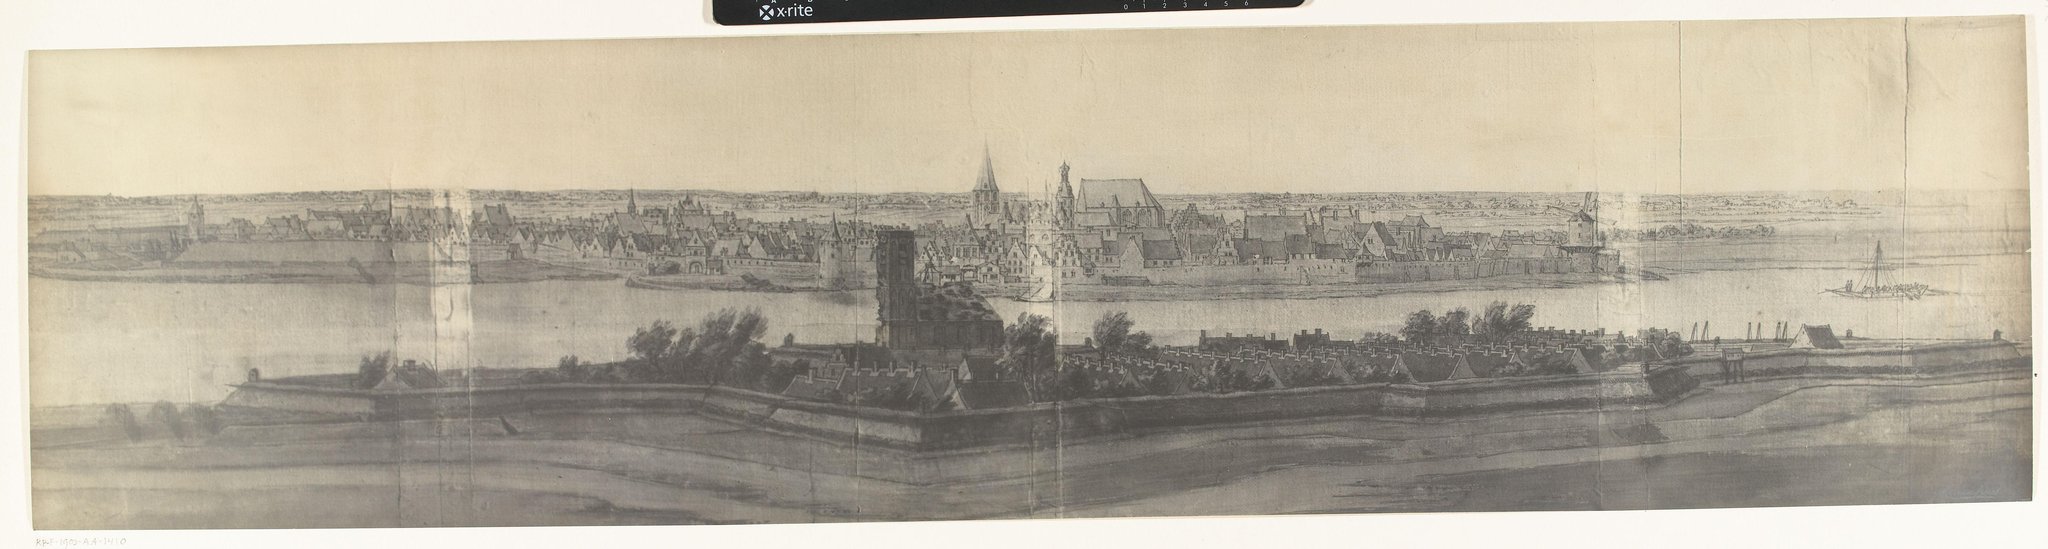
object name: photograph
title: Foto's van tekeningen van de Franse inval in de Nederlanden in 1672 door Adam Frans van der Meulen bewaard in de Manufacture des Gobelins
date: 1900-1903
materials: paper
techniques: gelatin silver print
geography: france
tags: lodewijk xiv (koning van frankrijk), prospect of city, town panorama, silhouette of city, rampjaar (disaster year)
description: Niet in Frederik Muller; door het RPK toegevoegd nummer. Onderdeel van een groep van ca. 50 foto's van tekeningen van de Franse inval in de Nederlanden in 1672 door Adam Frans van der Meulen, bewaard in de Manufacture Nationale des Gobelins te Parijs.